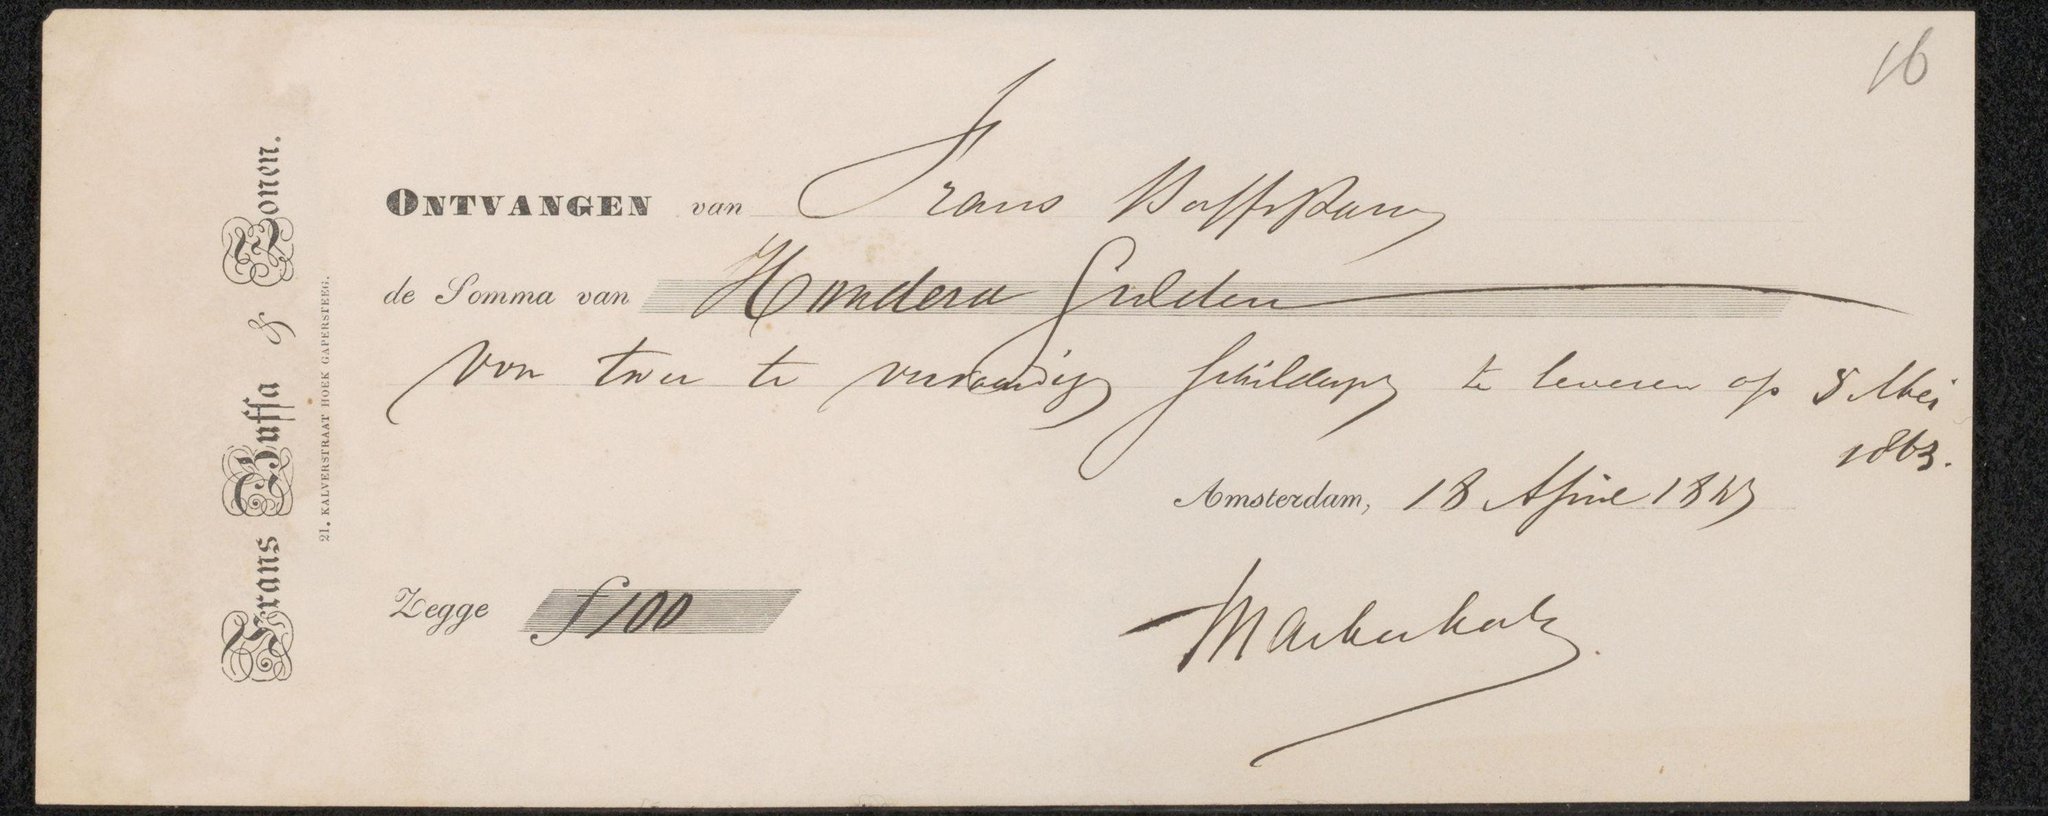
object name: ontvangstbewijs, kwitantie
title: Kwitantie voor Mari ten Kate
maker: mari ten kate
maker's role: draughtsman, painter, print maker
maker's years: 1831-1910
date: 1863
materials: ink, paper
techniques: pen, printing, writing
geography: amsterdam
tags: painting (including book-illumination, miniature-painting), money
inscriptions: collector's mark: Lugt 2233